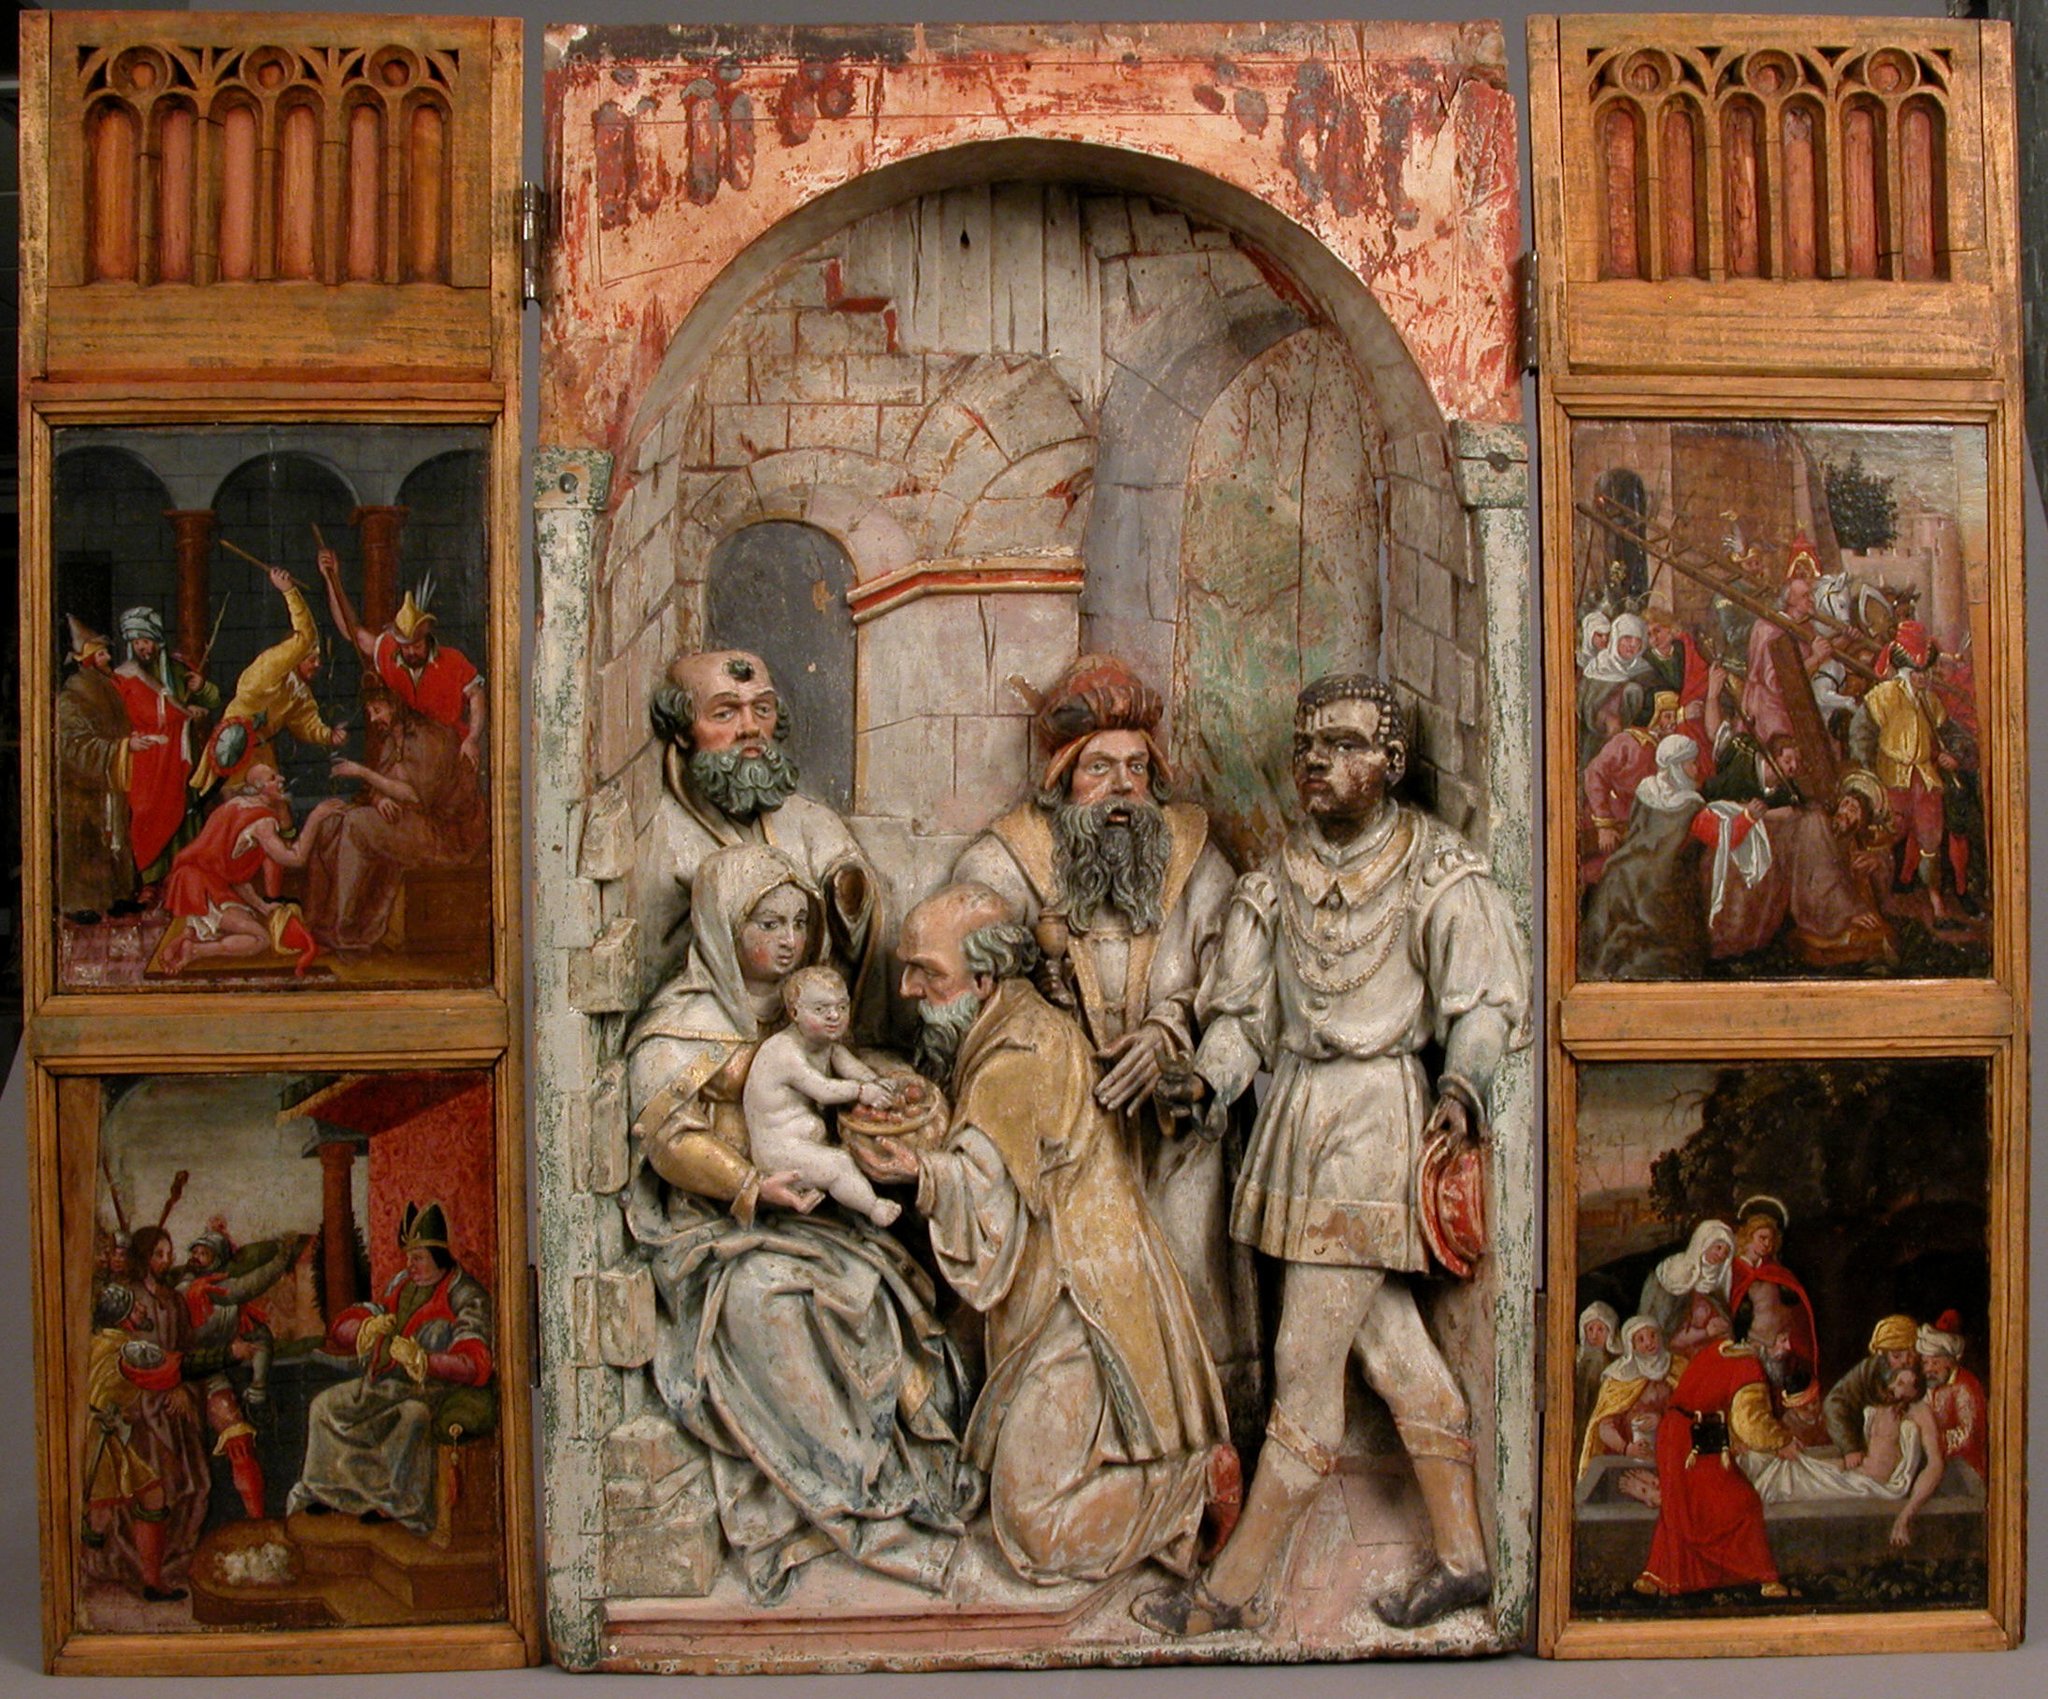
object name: triptych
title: Adoration of the Magi Triptych Panel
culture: german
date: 1501-1600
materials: gilt, panel, paint, wood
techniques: polychrome, relief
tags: men,women,christ,madonna and child